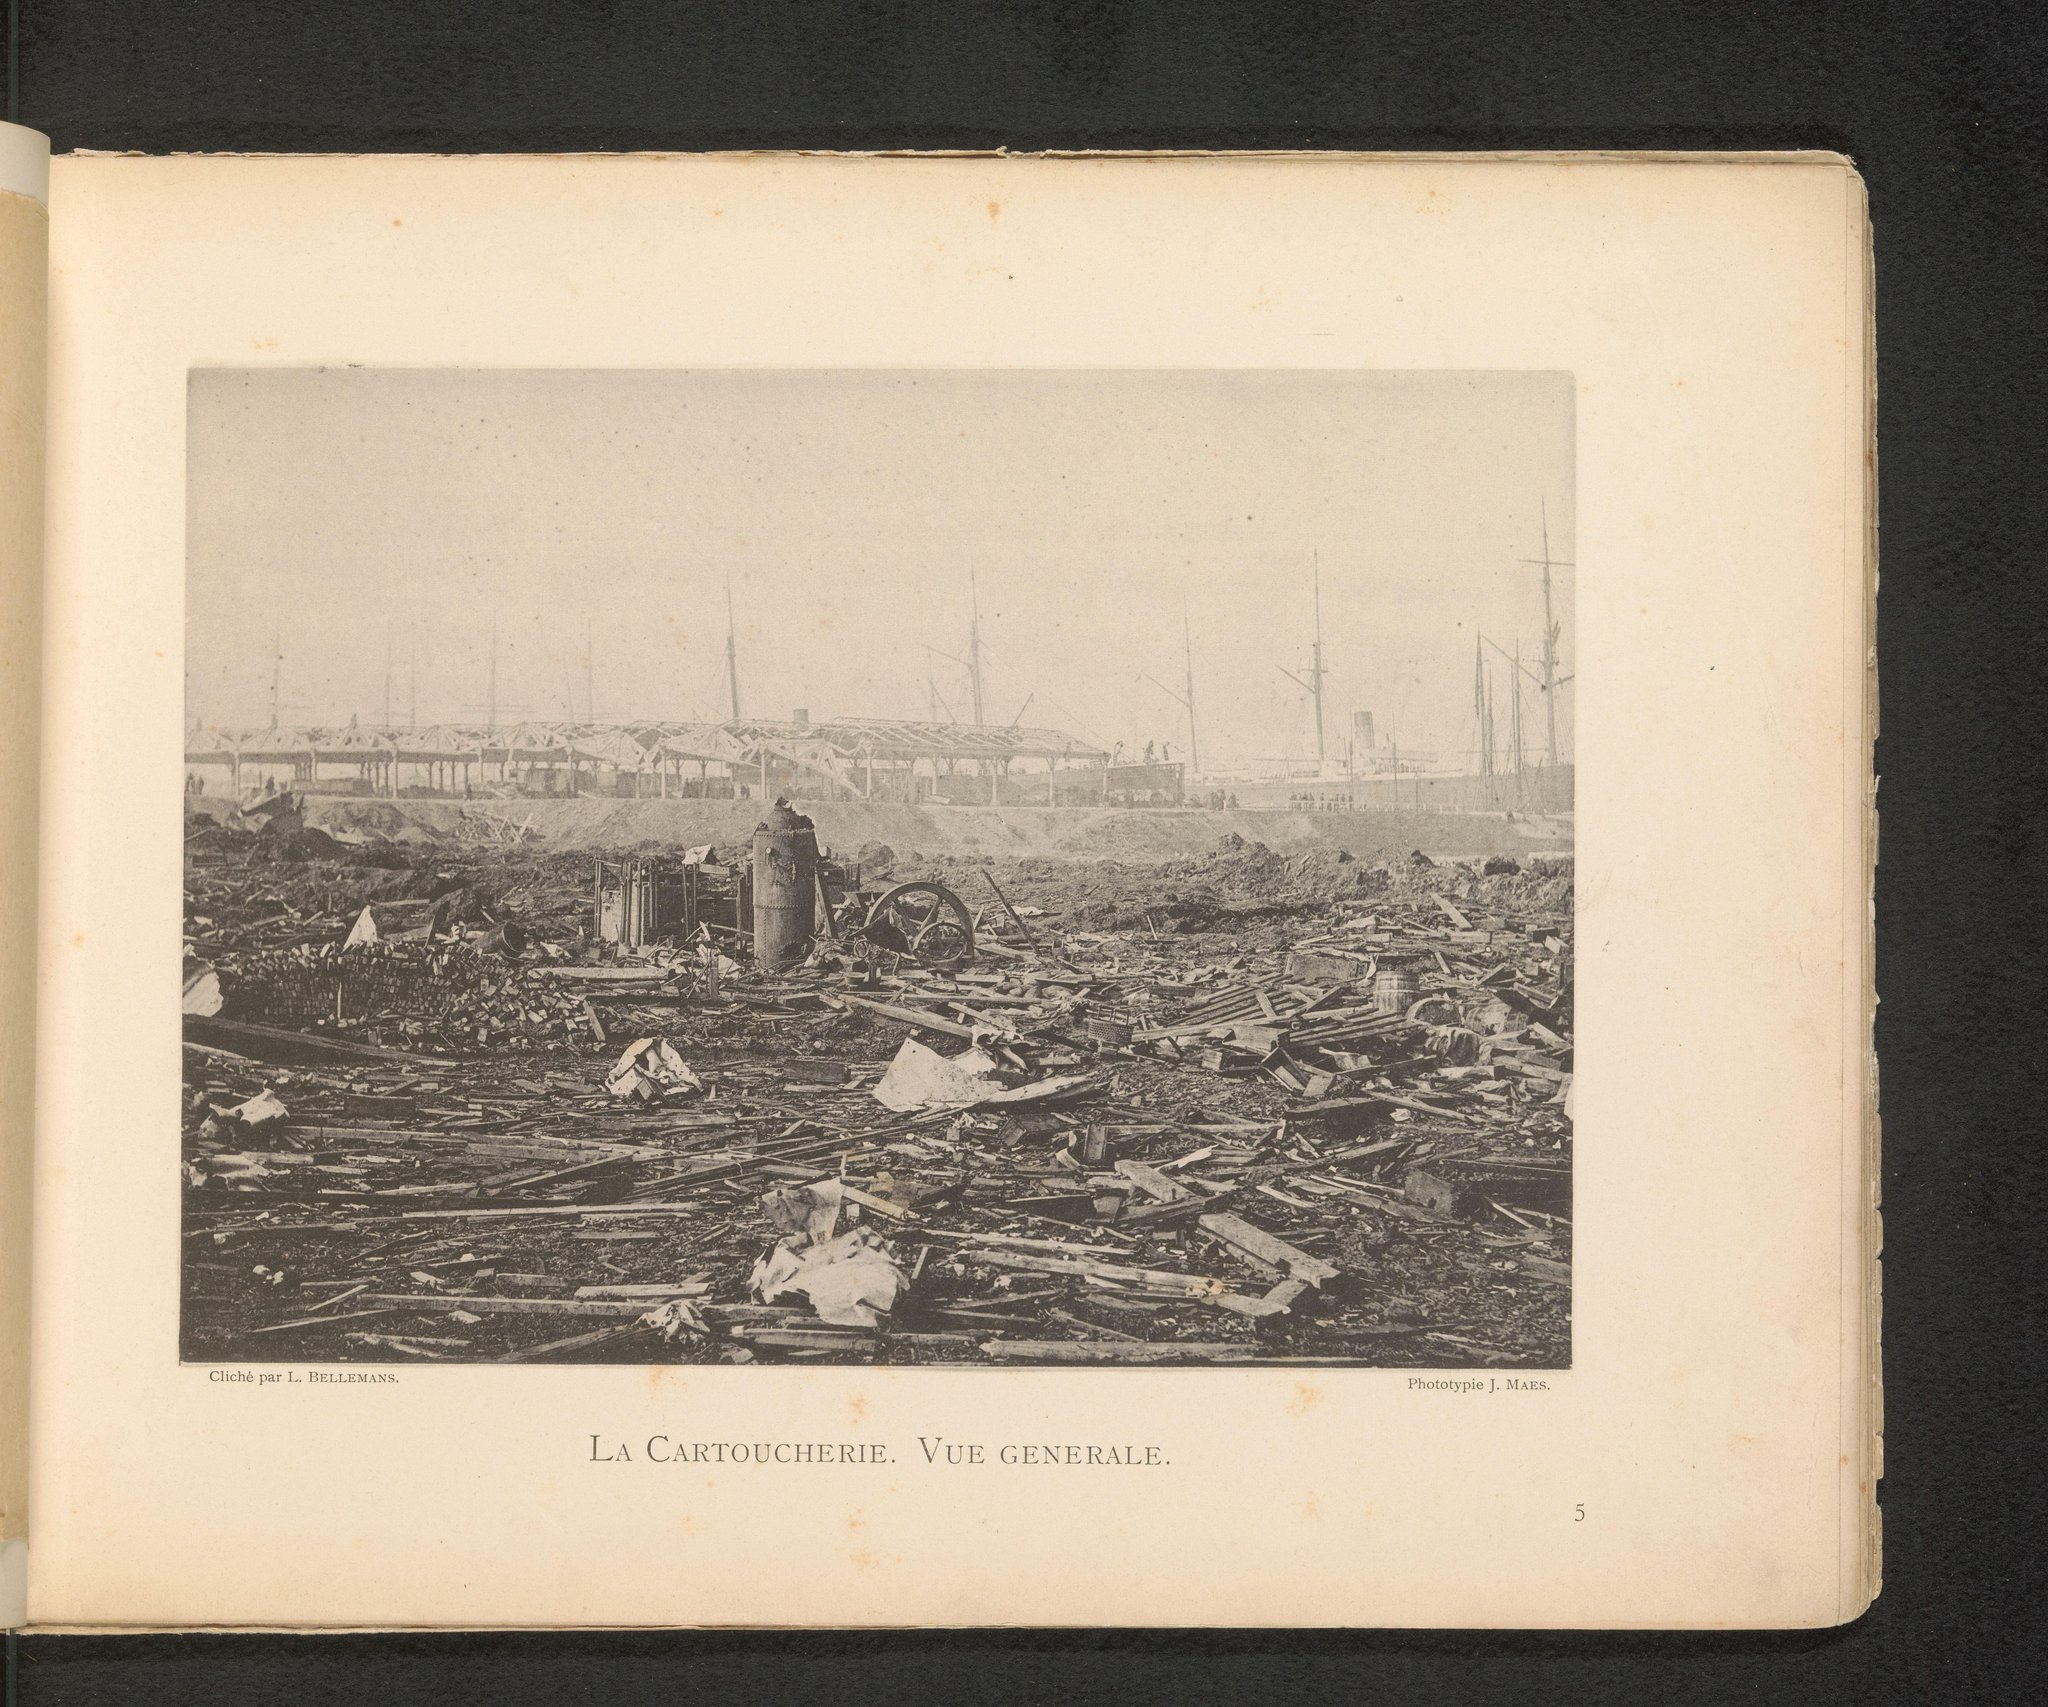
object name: photomechanical print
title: Resten van de munitiefabriek na de ontploffing in Oosterweel bij Antwerpen op 6 september 1889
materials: paper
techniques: photograph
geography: oosterweel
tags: ruin of a building ~ architecture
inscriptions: number: ‘5’